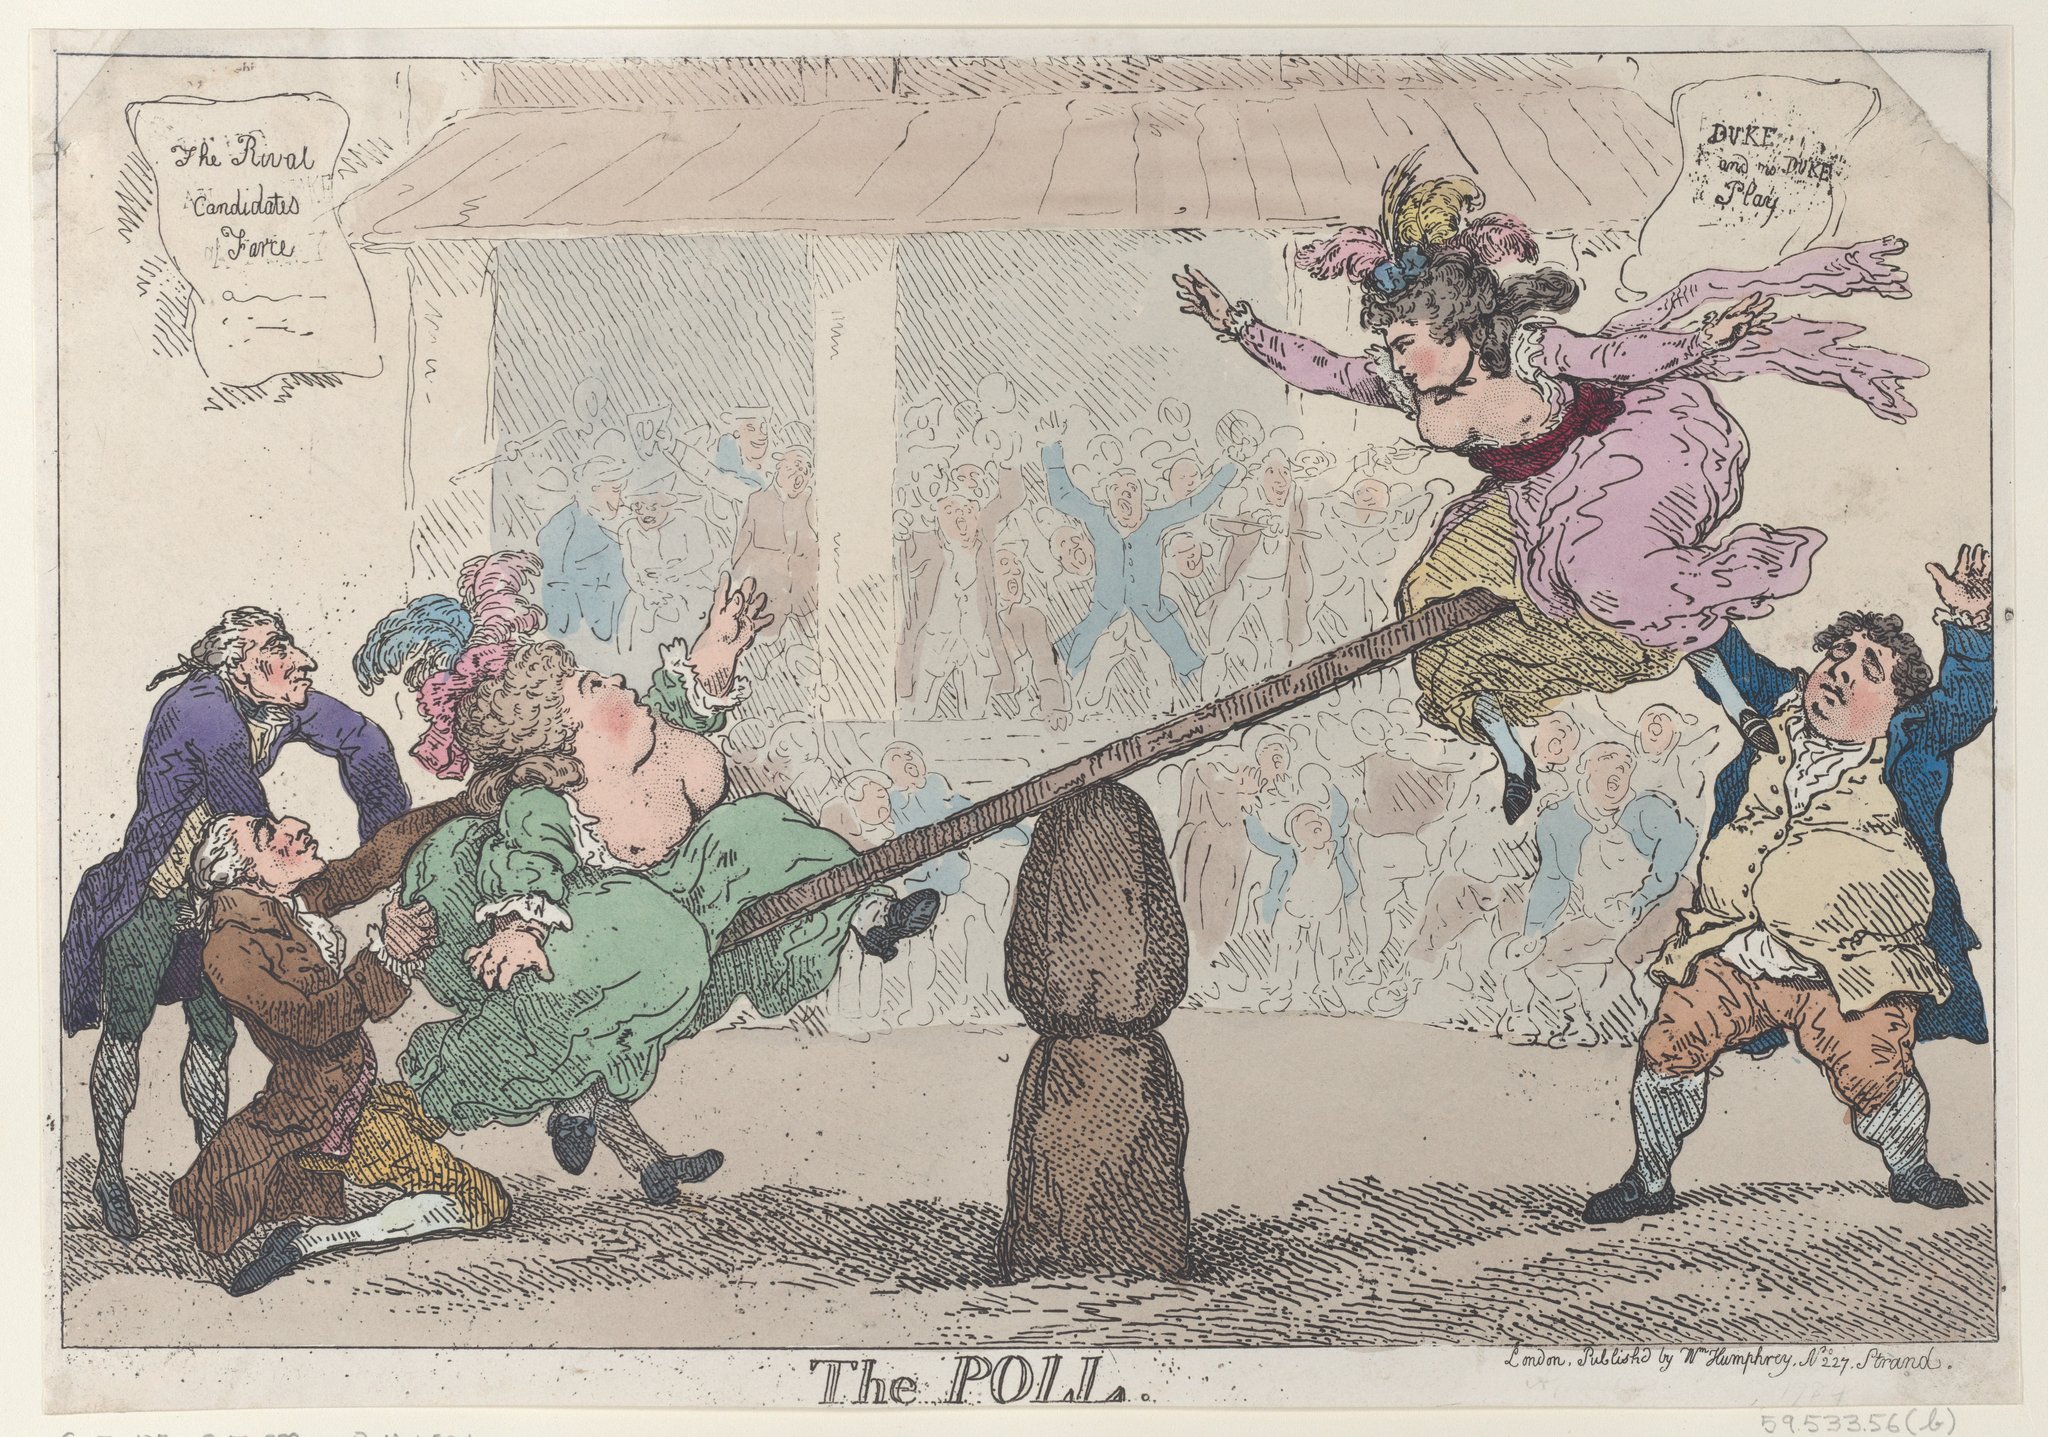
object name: print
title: The Poll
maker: thomas rowlandson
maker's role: artist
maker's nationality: british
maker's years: 1757-1827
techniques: etching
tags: satire,men,women,politics